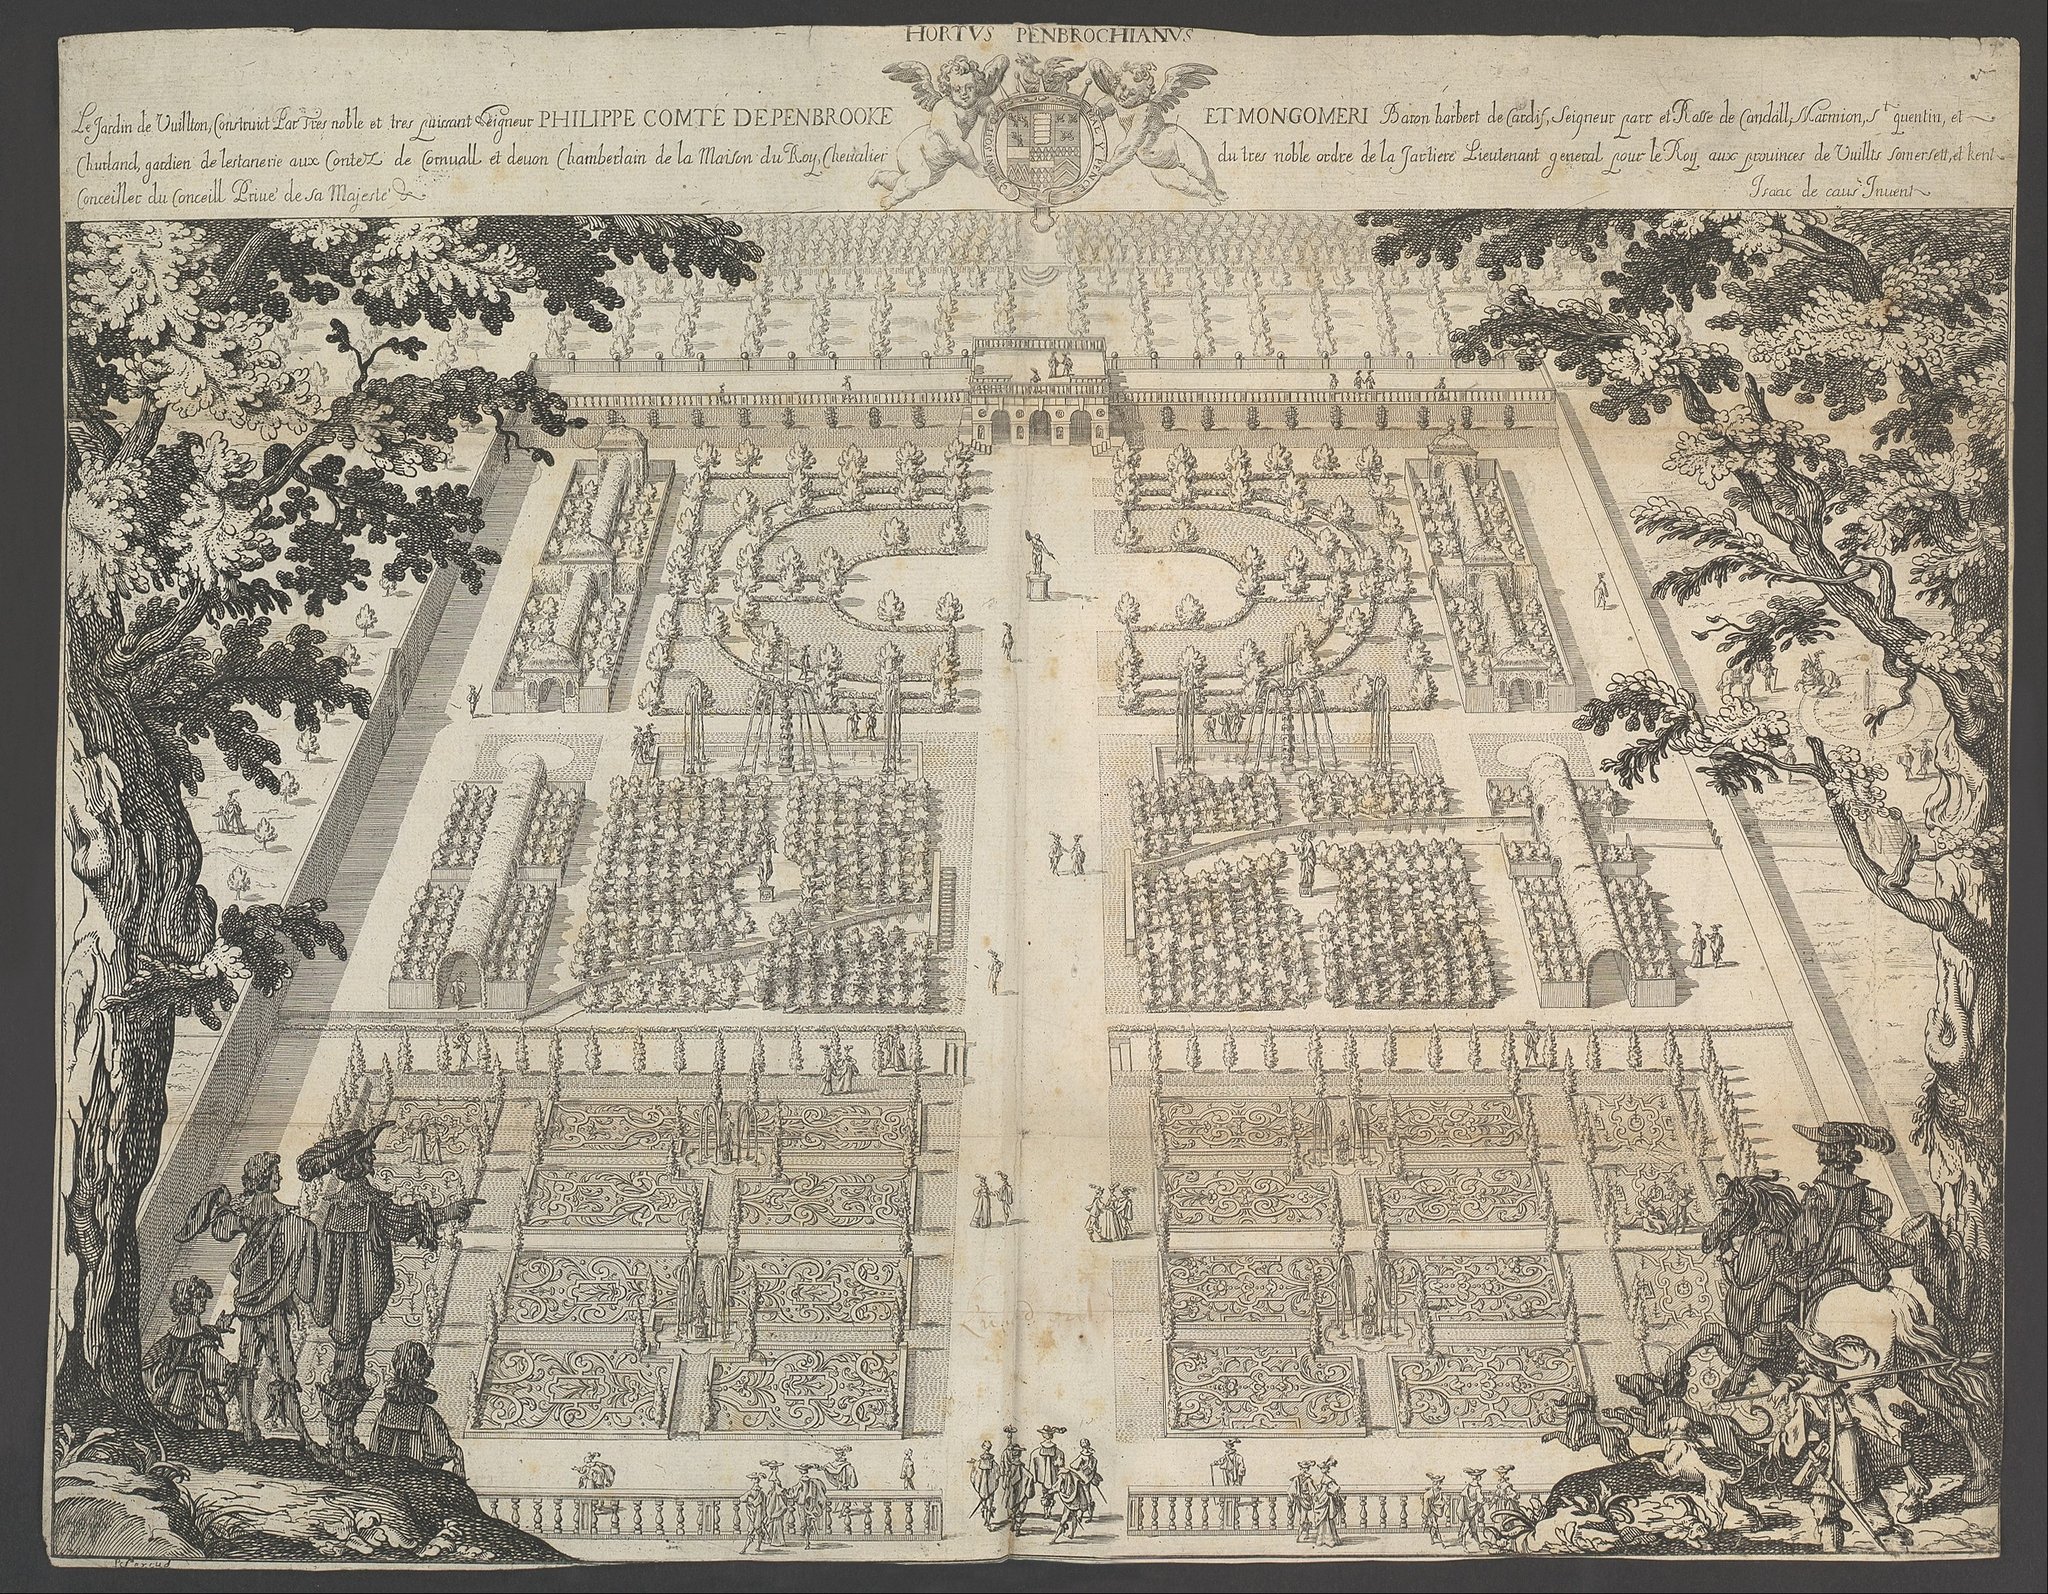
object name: book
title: Wilton Garden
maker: isaac de caus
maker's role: designer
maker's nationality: british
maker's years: 1590-1655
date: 1640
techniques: etching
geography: england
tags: gardens,coat of arms